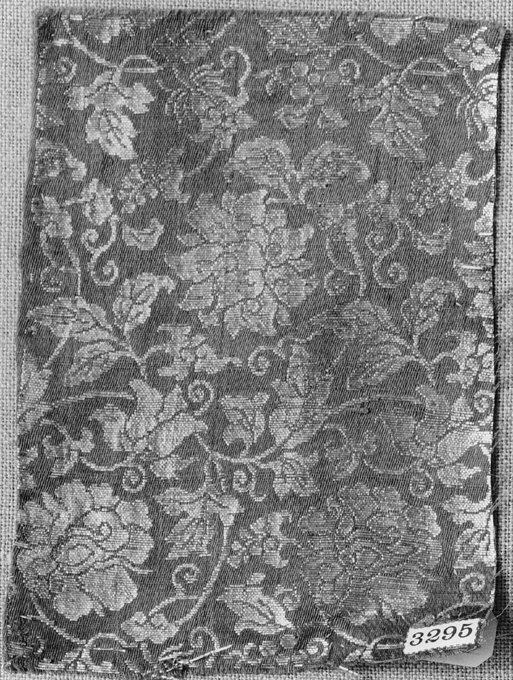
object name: piece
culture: japanese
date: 1801-1900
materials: silk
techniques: brocade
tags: leaves